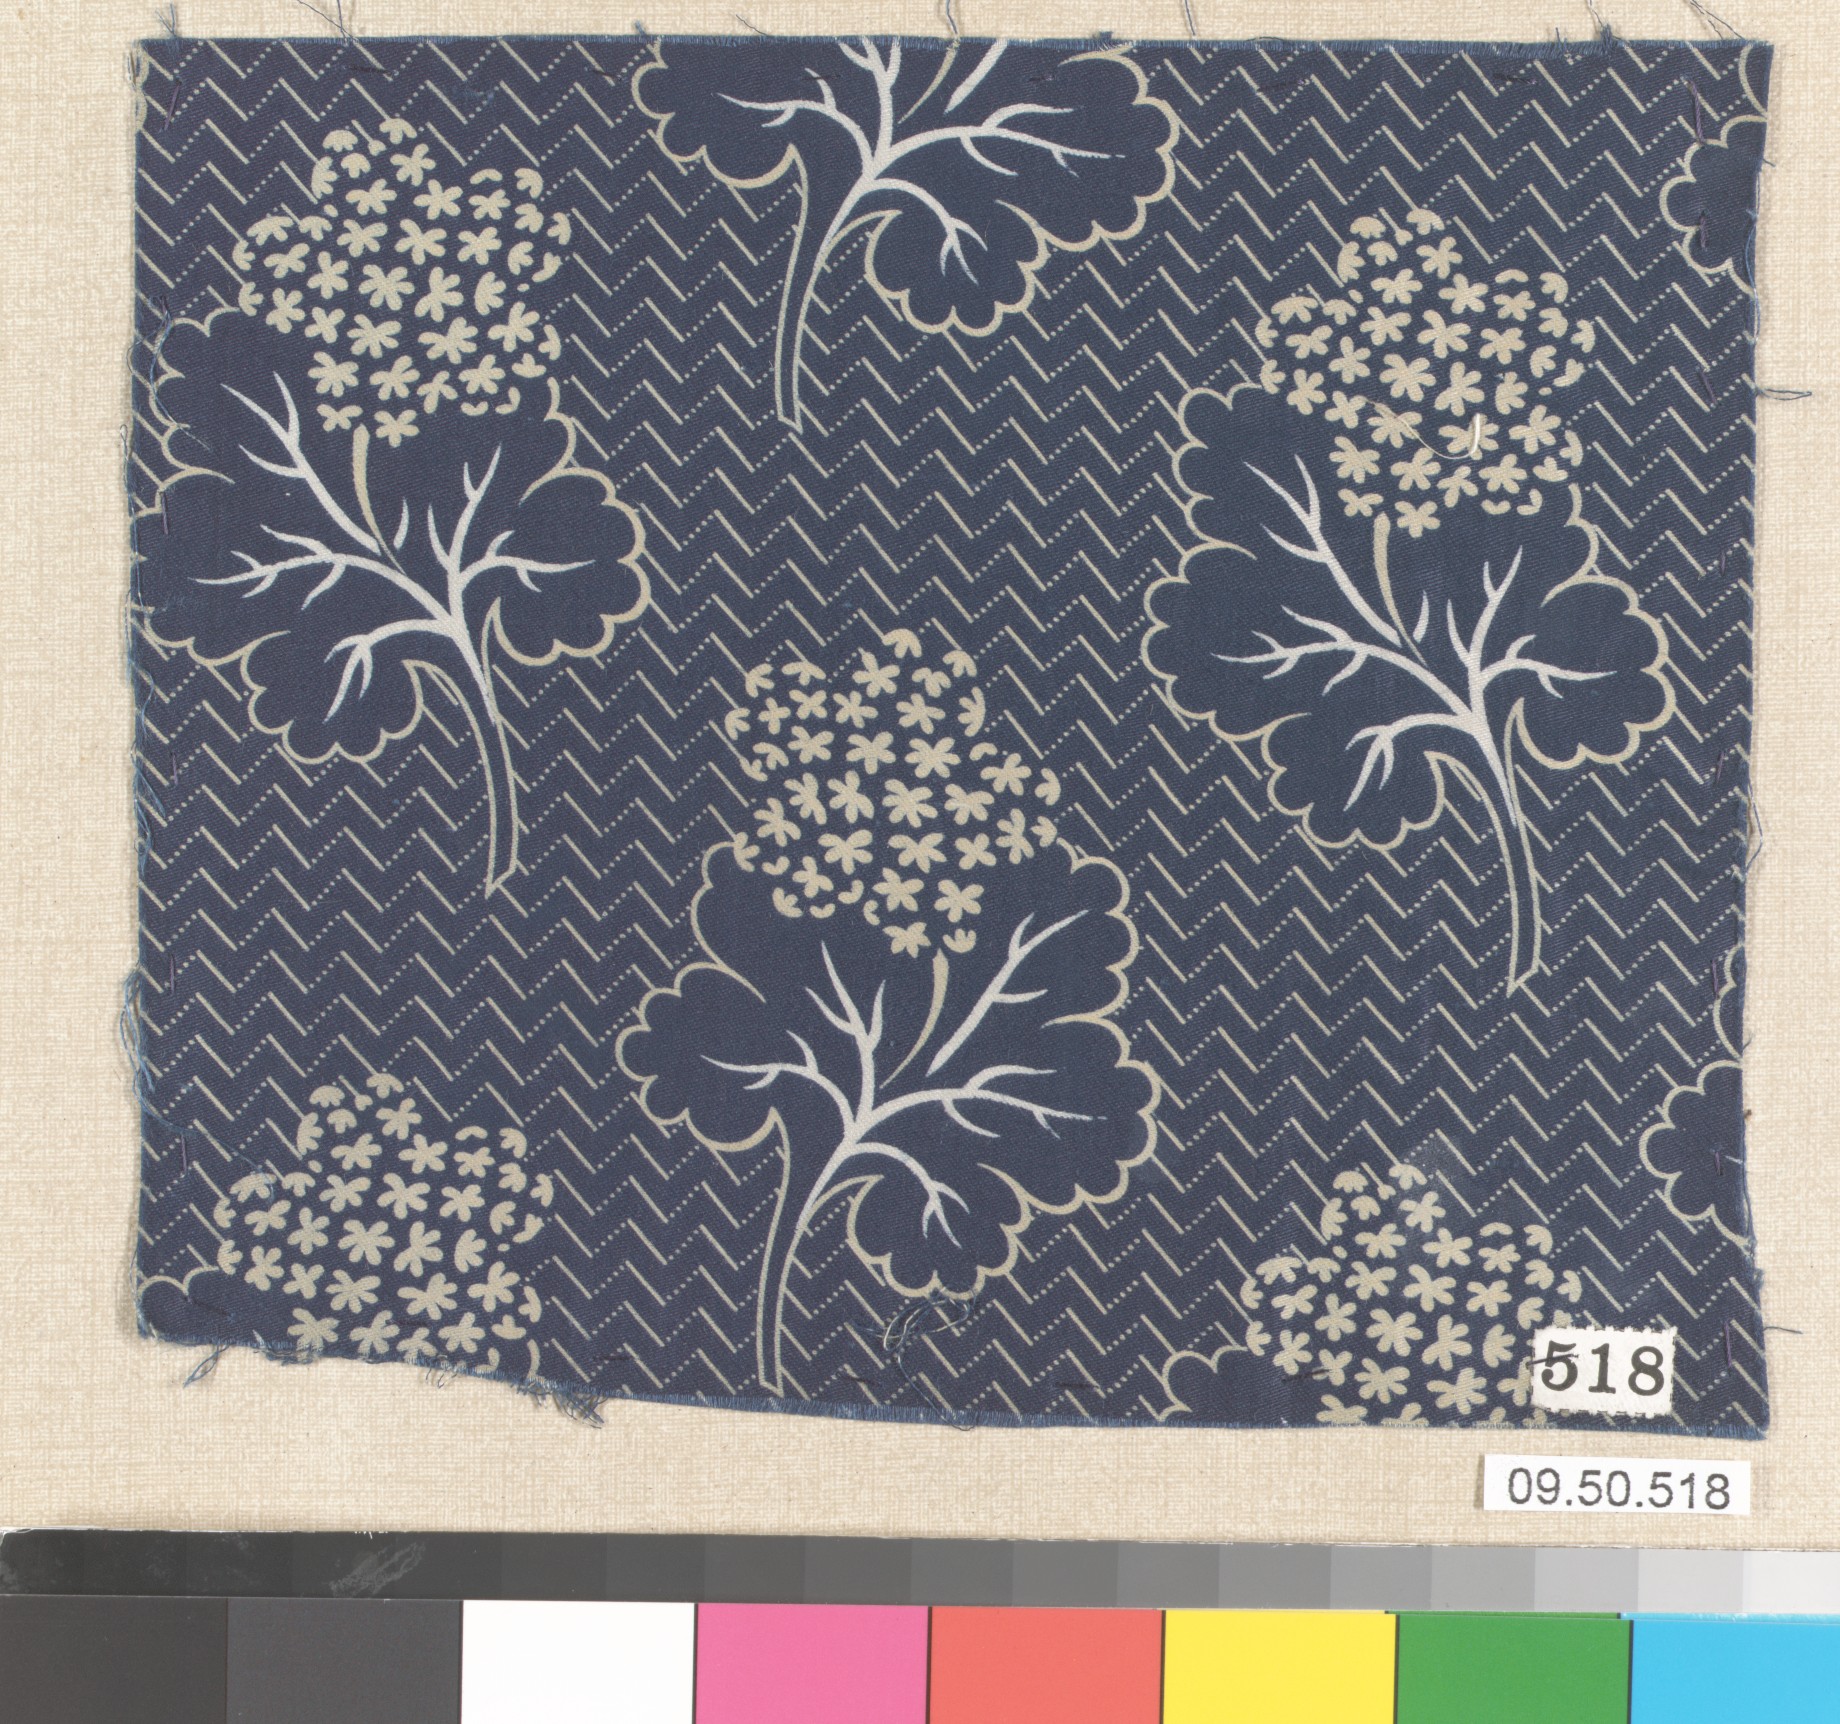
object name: piece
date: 1801-1900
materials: cotton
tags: leaves